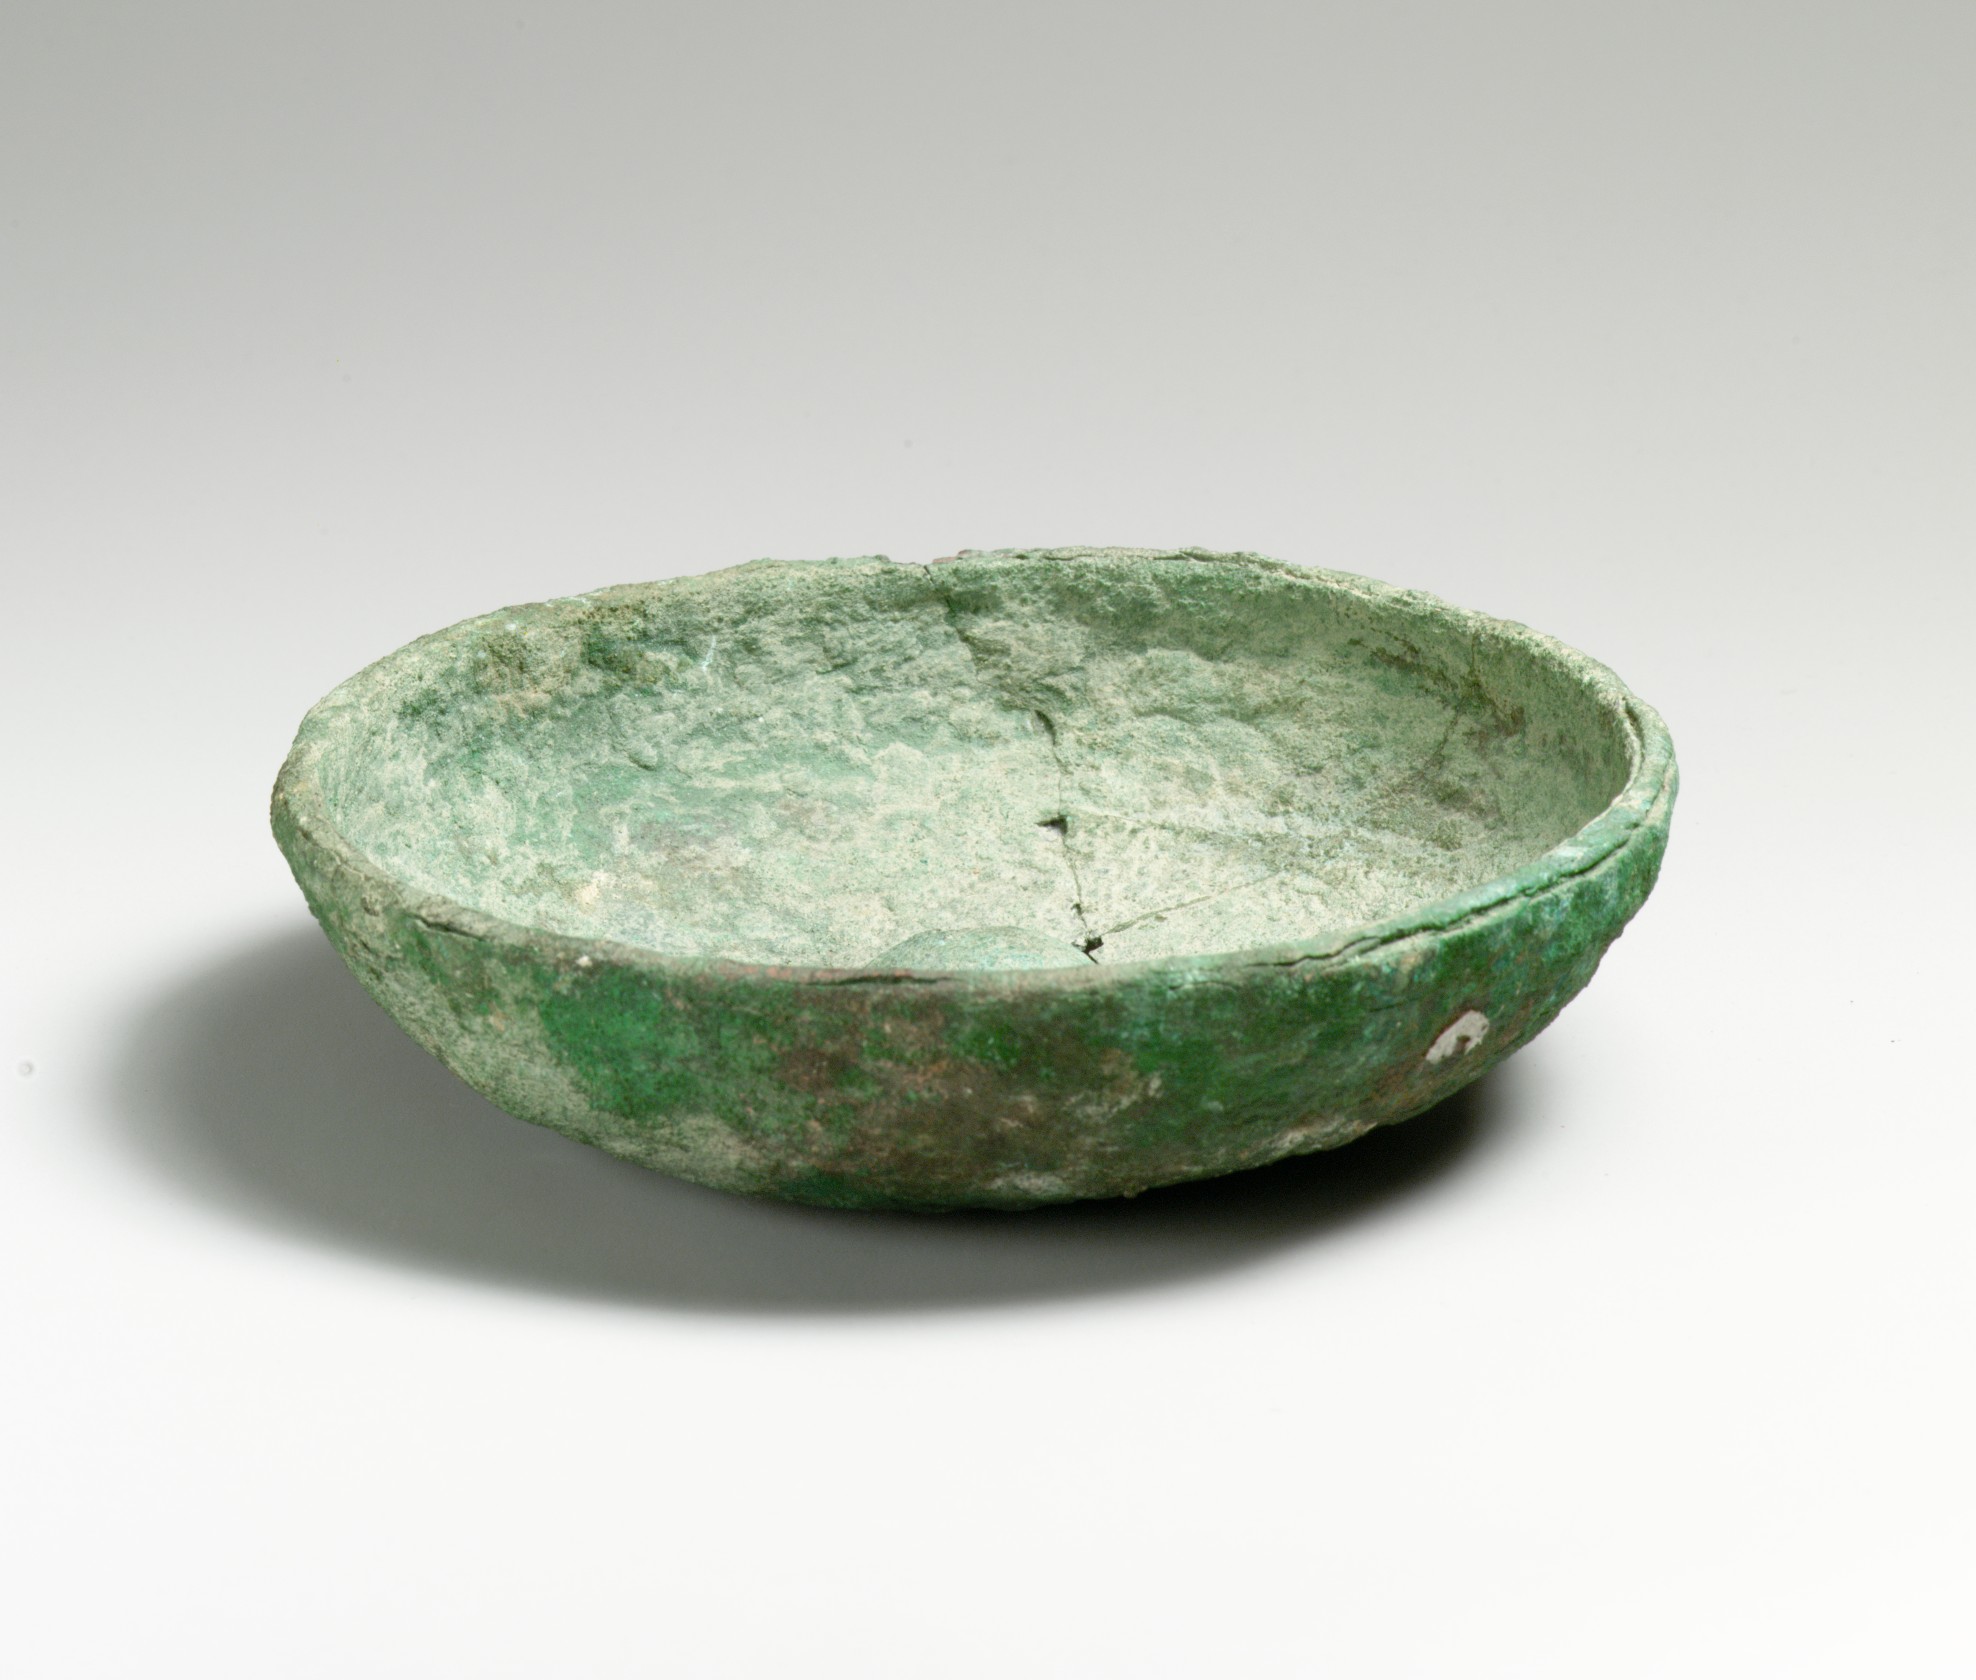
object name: phiale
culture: cypriot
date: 500-401 BCE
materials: bronze